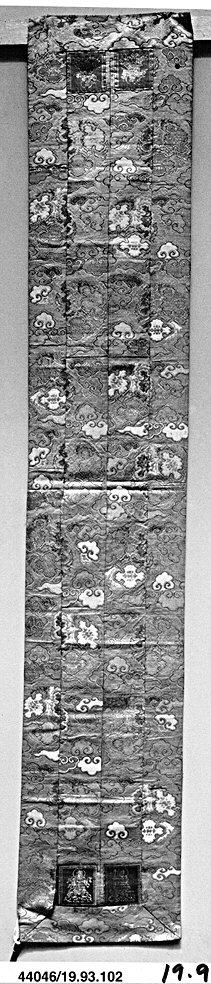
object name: stole, priest's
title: Priest's Stole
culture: japanese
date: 1625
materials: metal thread, silk